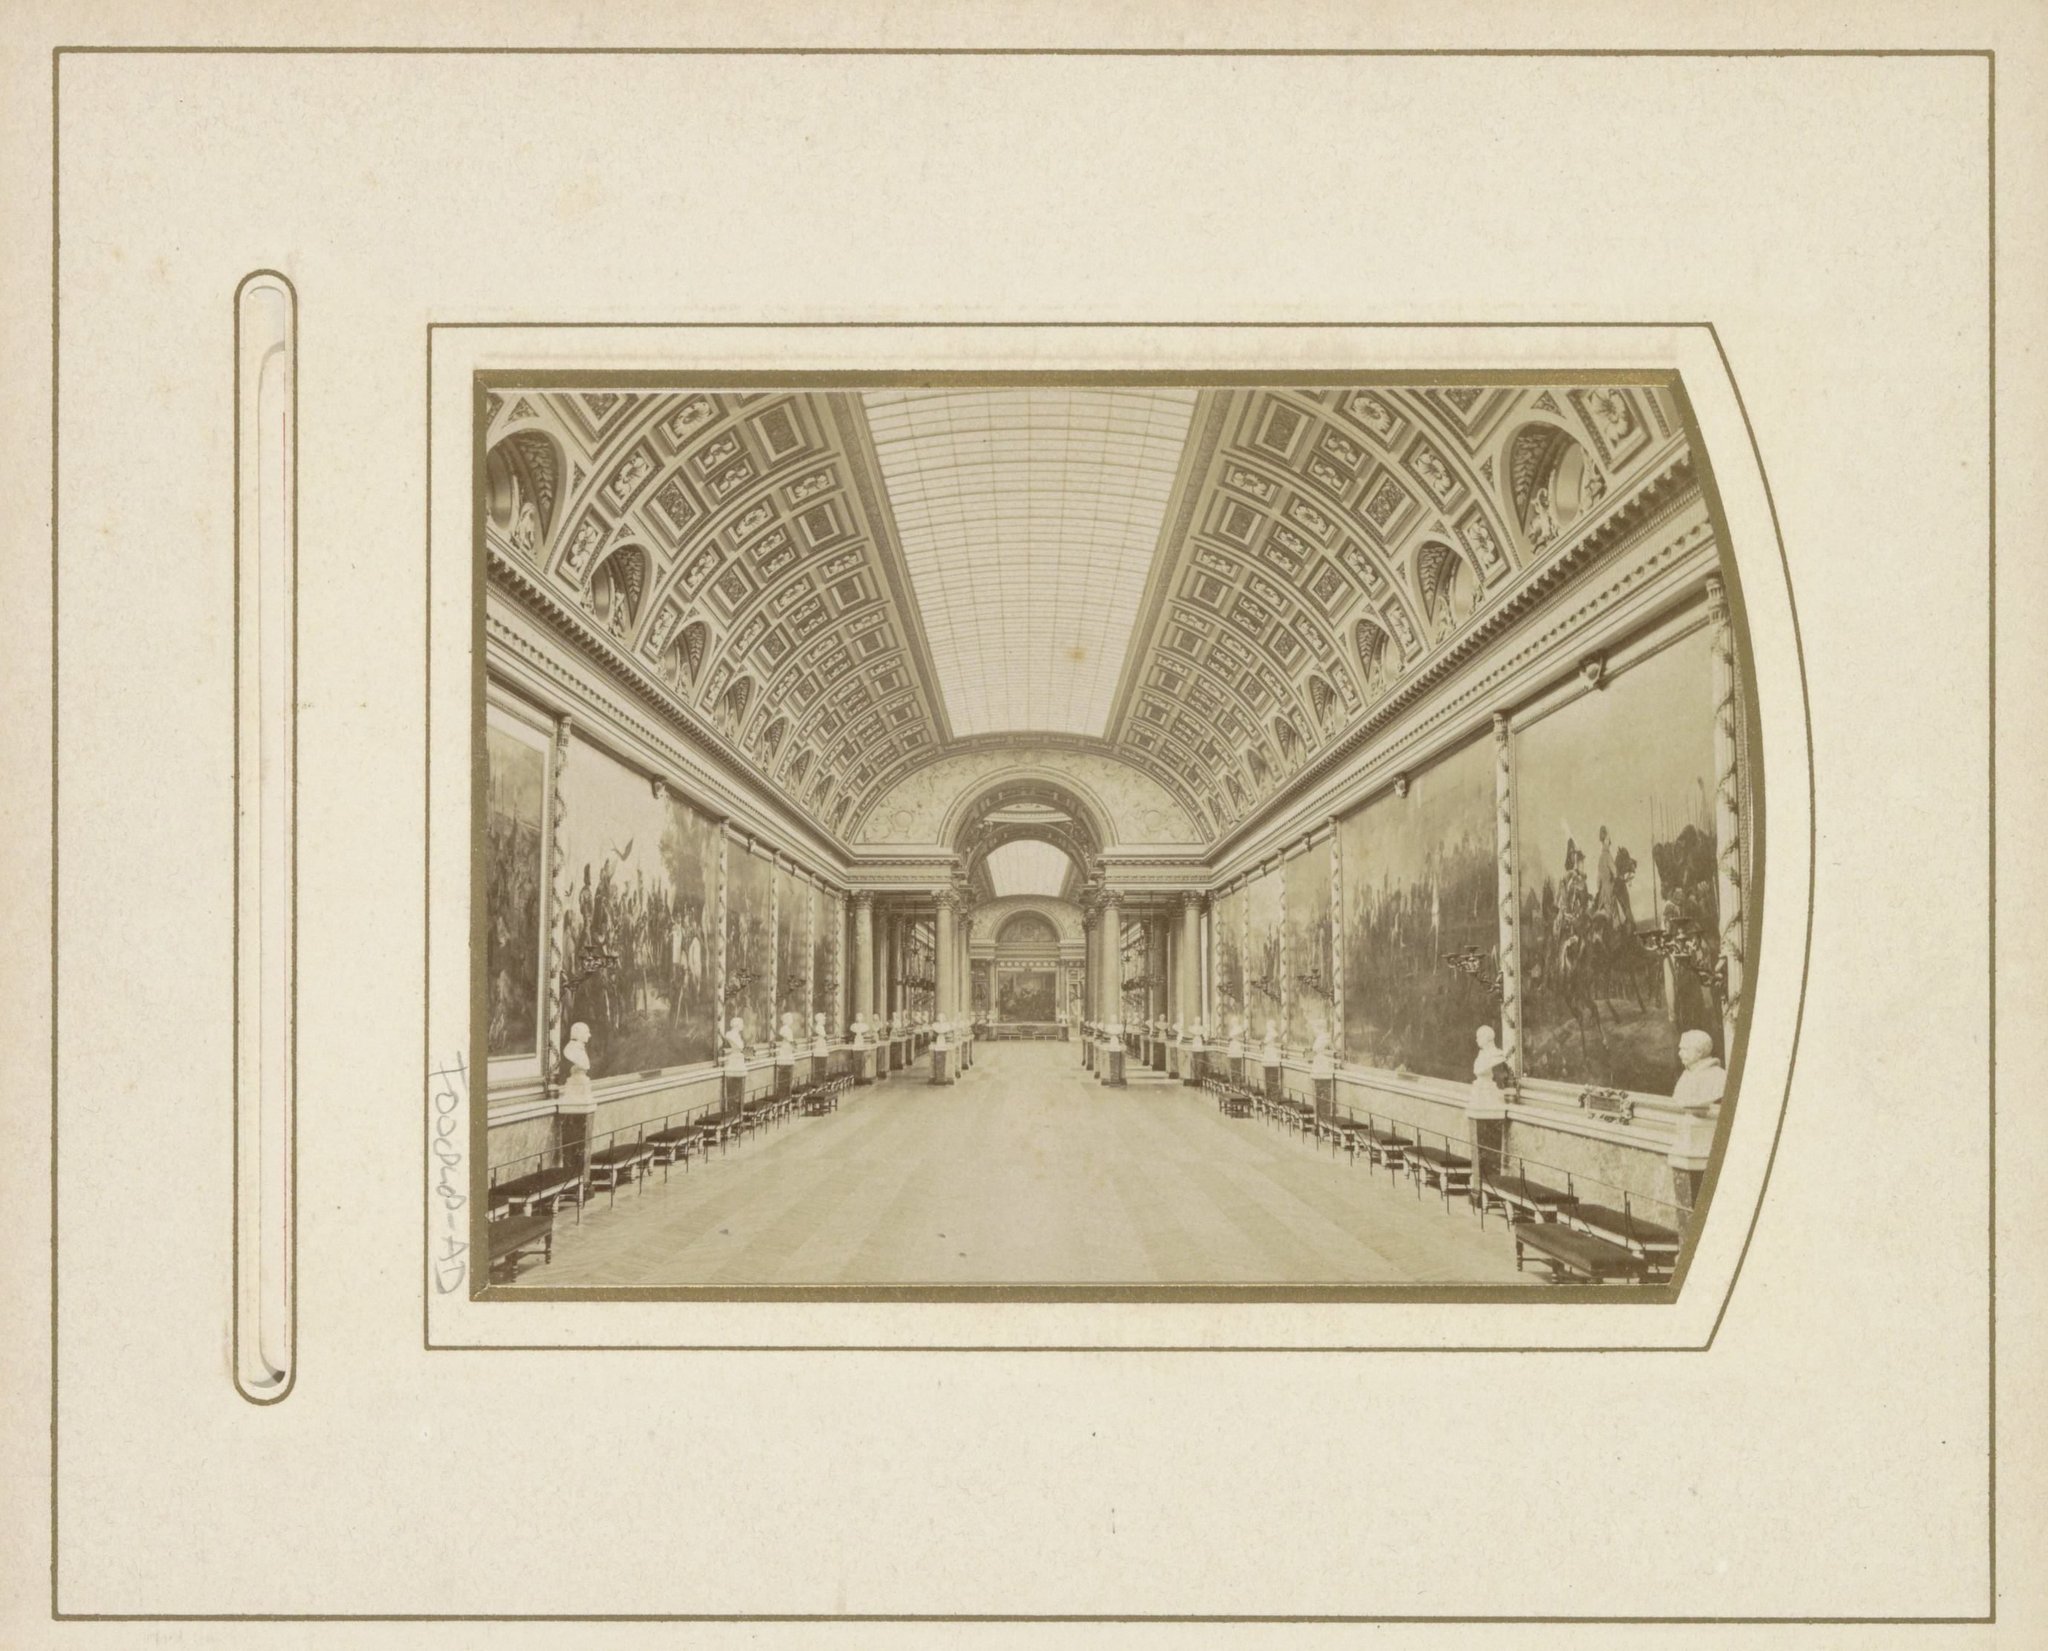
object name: cabinet photograph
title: Galerie des Batailles. Versailles.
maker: ll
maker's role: fotograaf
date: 1870-1900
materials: cardboard, paper, photographic support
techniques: albumen print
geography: versailles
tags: gallery (spacious corridor), permanent exhibition, museum, picture, painting, paris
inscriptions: inscription: ‘Maison Martinet Albert Hautecoeur 12, Bd des Capucines’, number: ‘18.’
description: Onderdeel van Fotoalbum met kabinetfoto's van bezienswaardigheden in Parijs en Versailles.